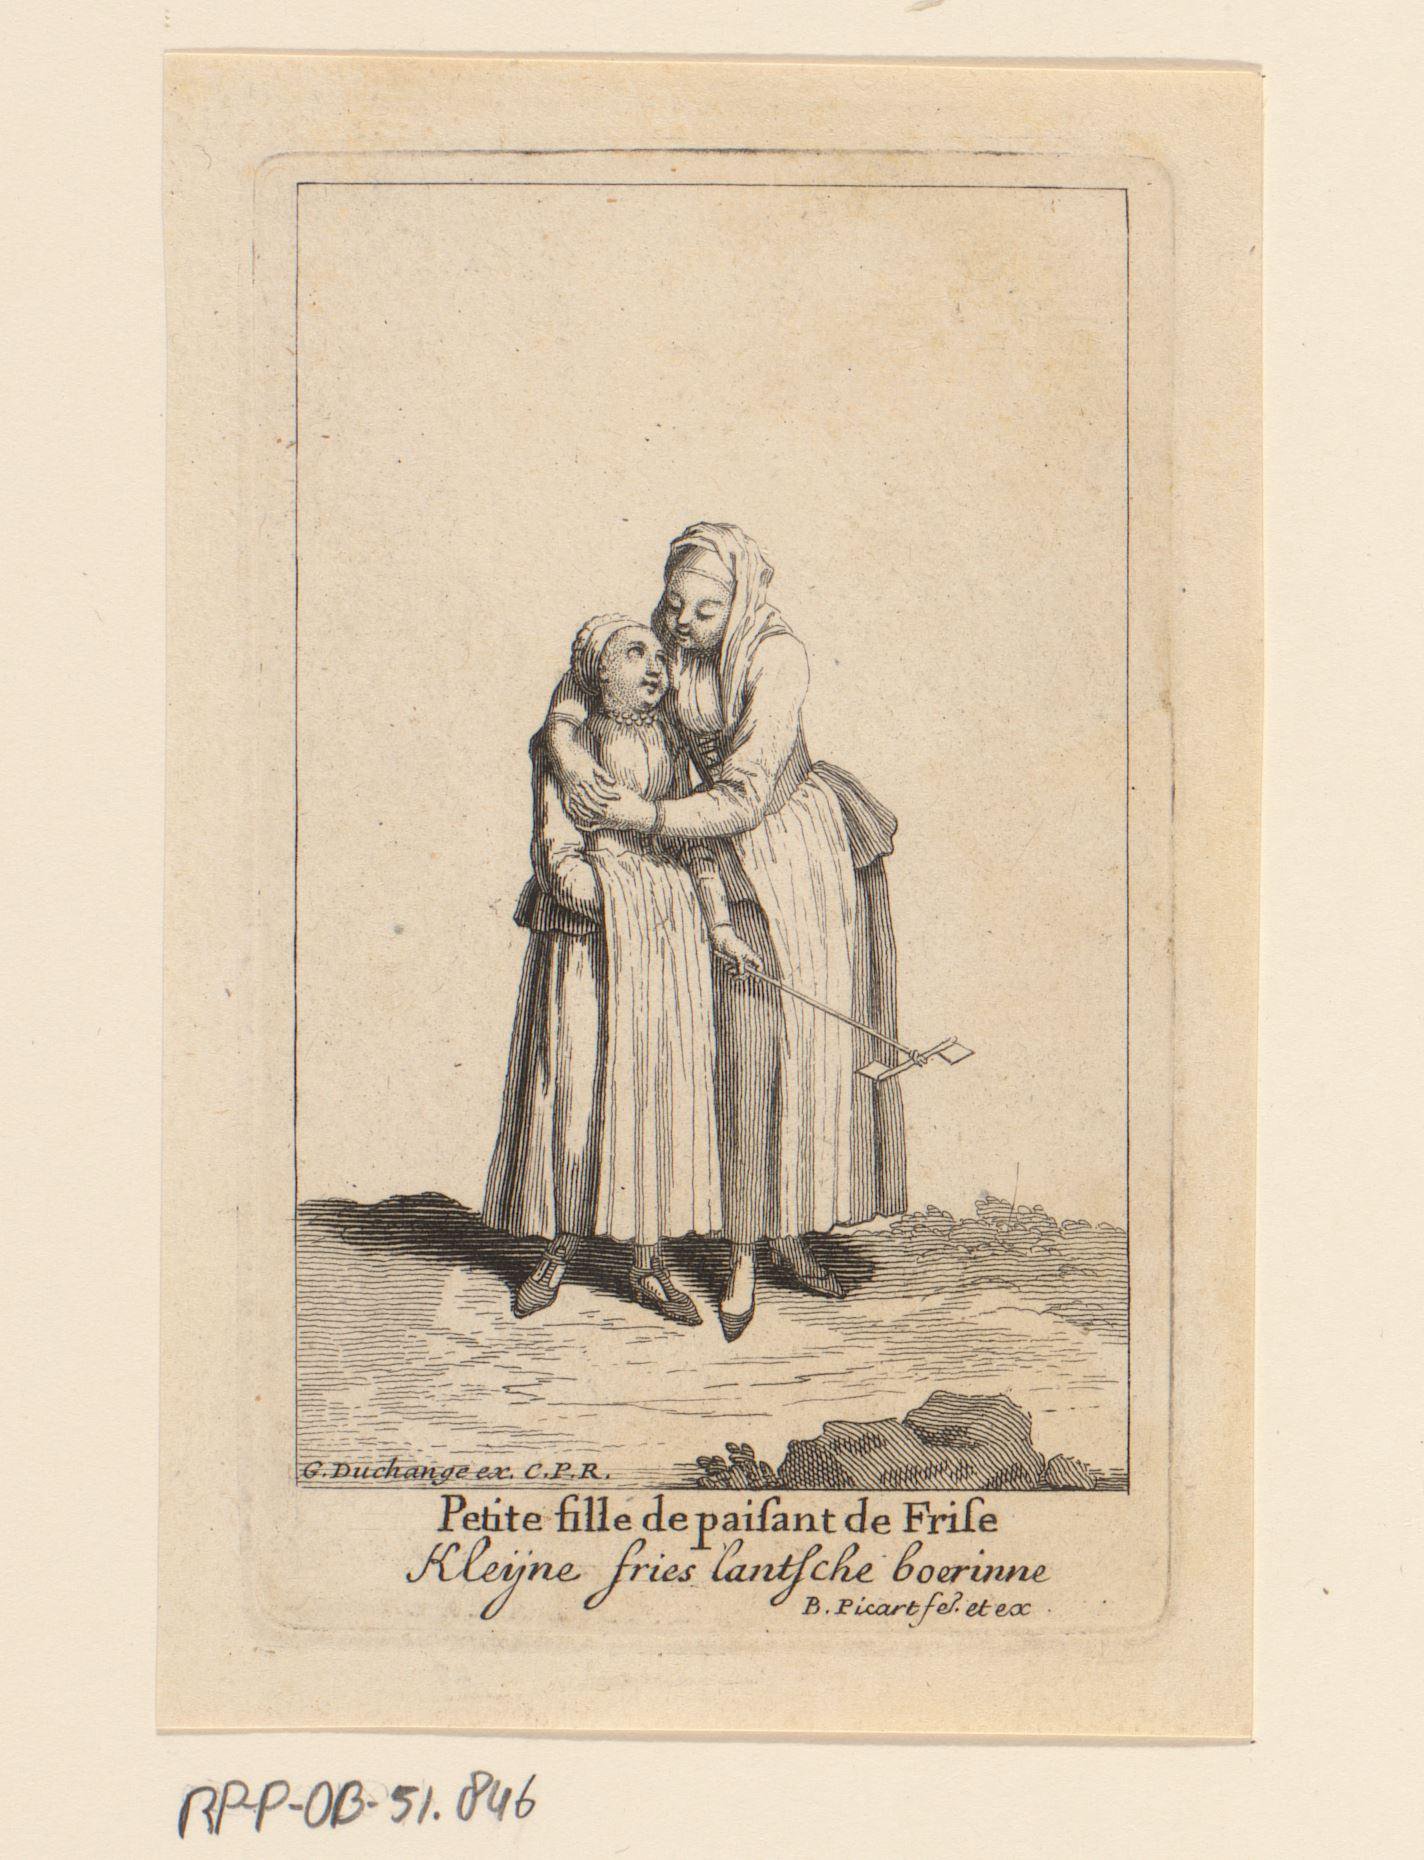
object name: print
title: Friese boerin met haar dochter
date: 1728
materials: paper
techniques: engraving, etching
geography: amsterdam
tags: folk costume, regional costume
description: Prent waarschijnlijk ook opgenomen in: Diverses modes dessinées d'après Nature. Amsterdam: Bernard Picart, 1728.